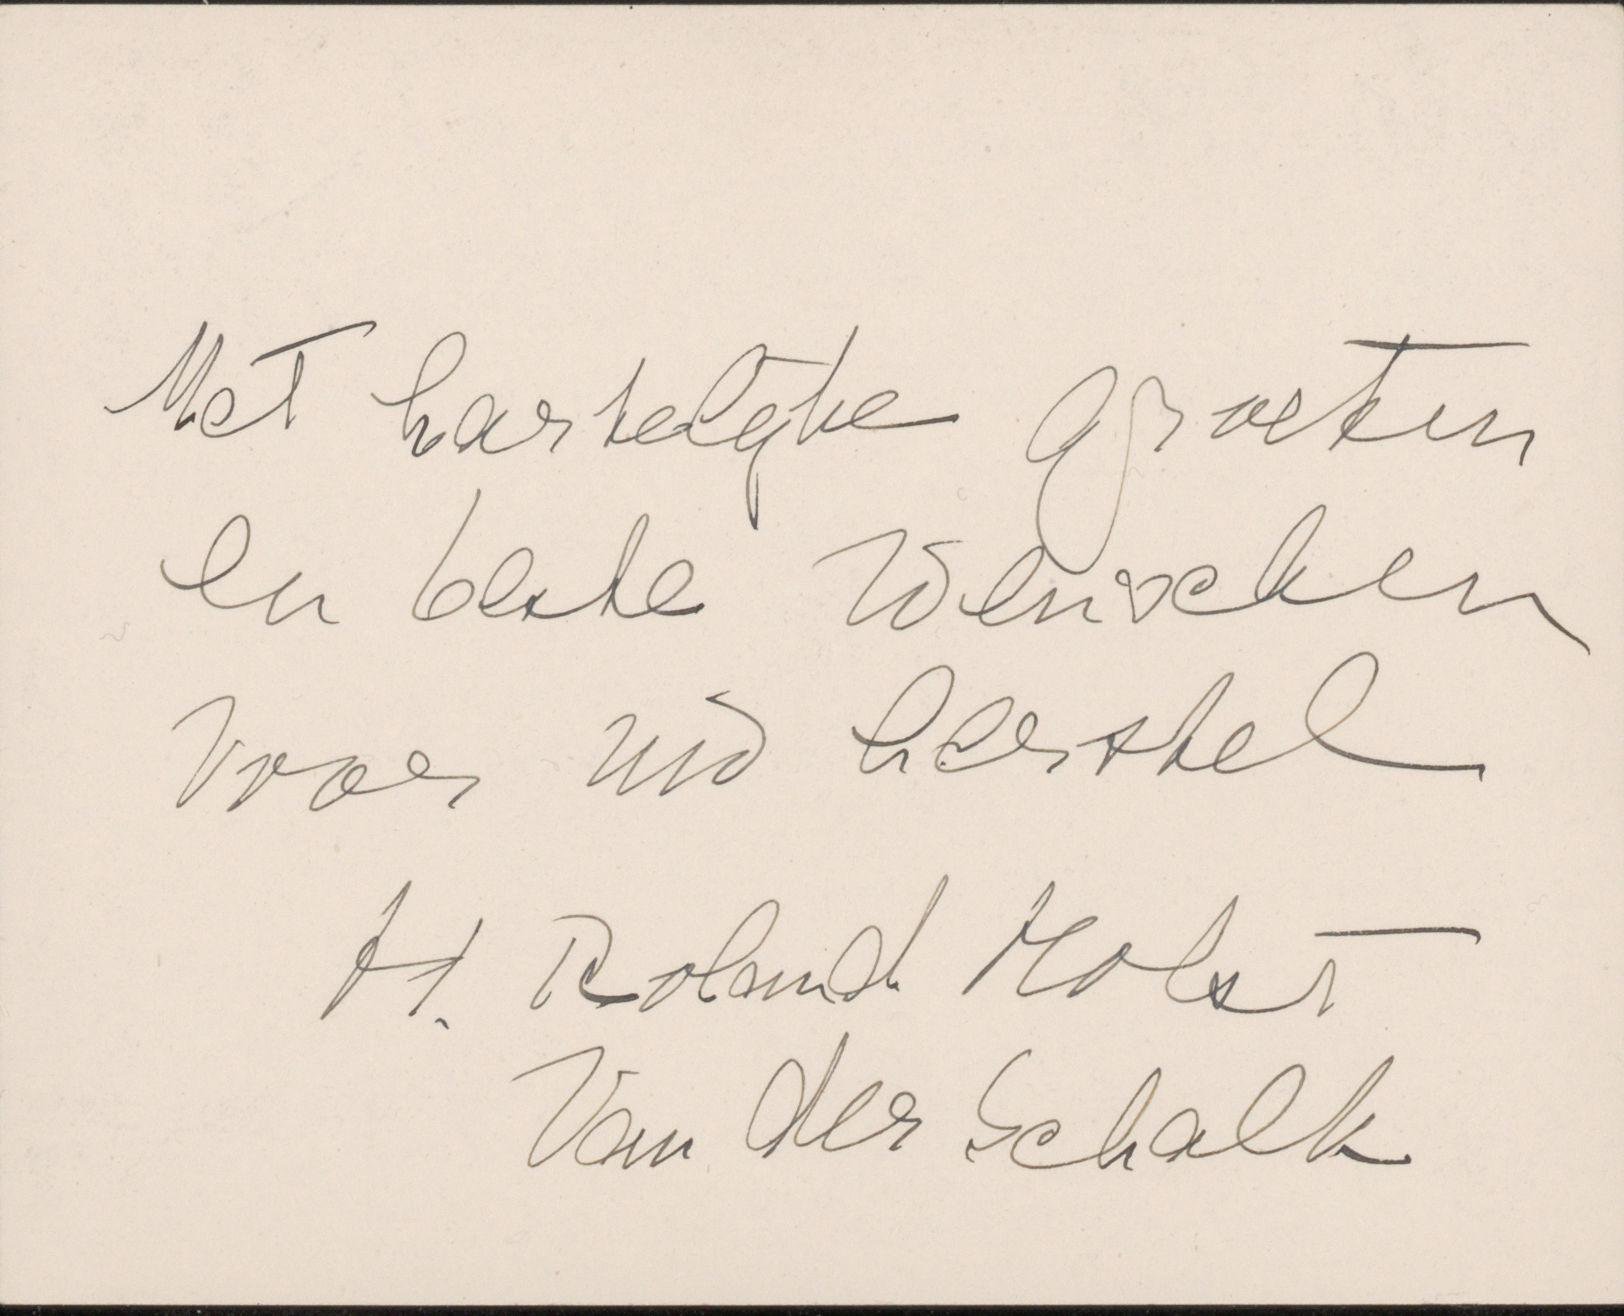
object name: letter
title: Brief aan Willem Bogtman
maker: henriëtte roland holst-van der schalk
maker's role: dichter, schrijver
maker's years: 1869-1952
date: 1928-1952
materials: ink, paper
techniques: pen, writing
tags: haarlem, willem bogtman, diseases